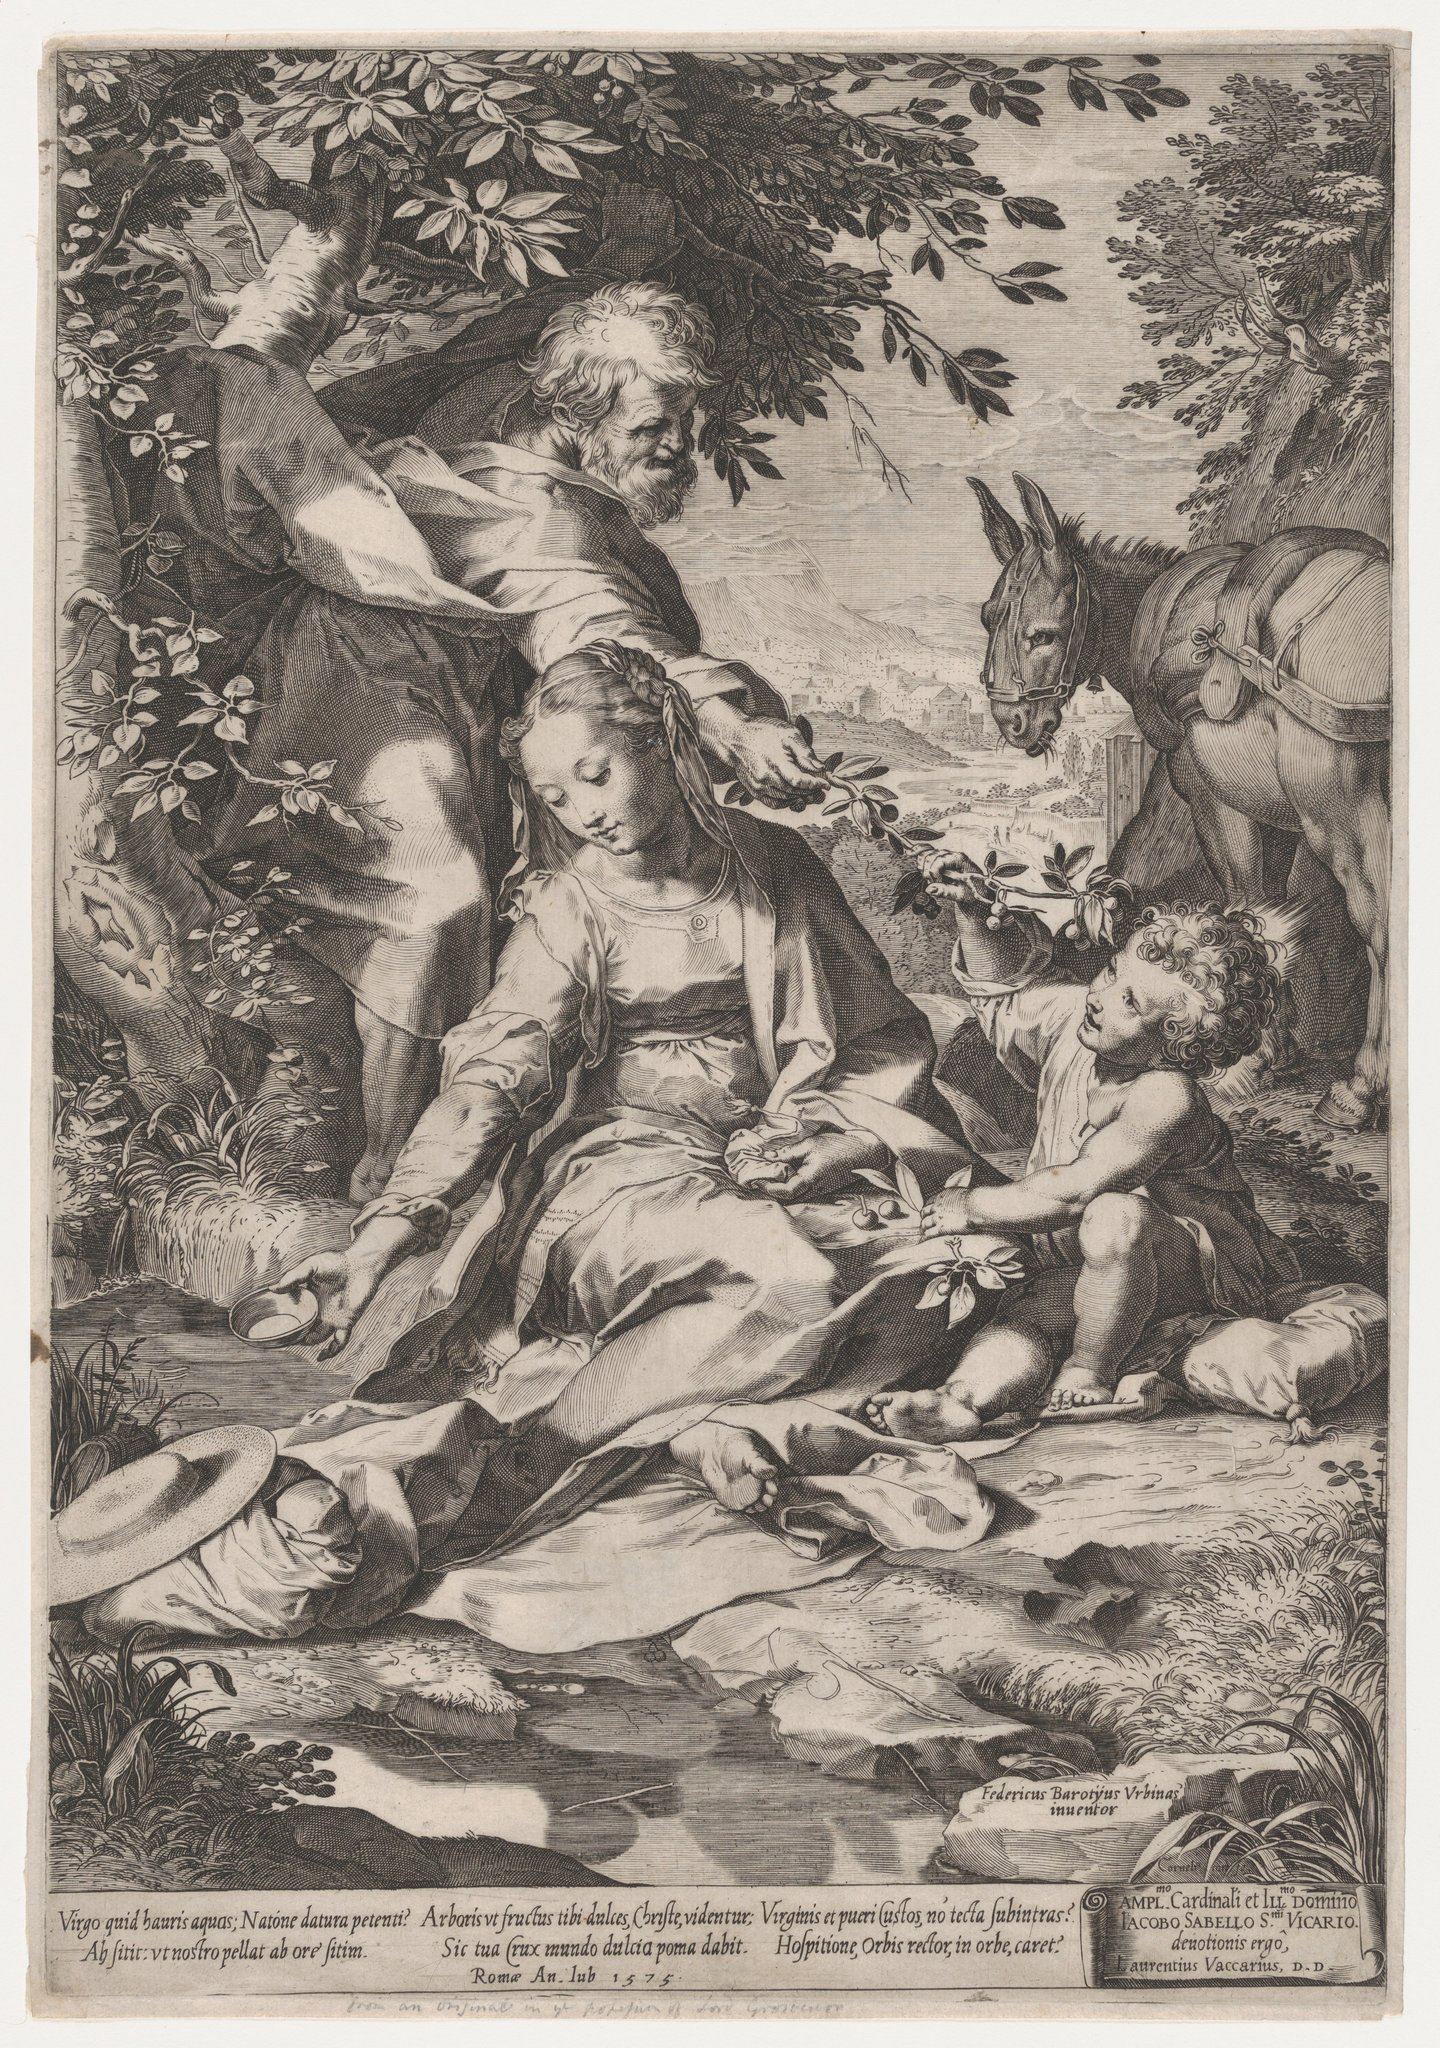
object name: print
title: The Rest on the Return from Egypt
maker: cornelis cort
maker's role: artist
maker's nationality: netherlandish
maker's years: 1533-1578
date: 1575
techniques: engraving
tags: donkeys,holy family,madonna and child,saints